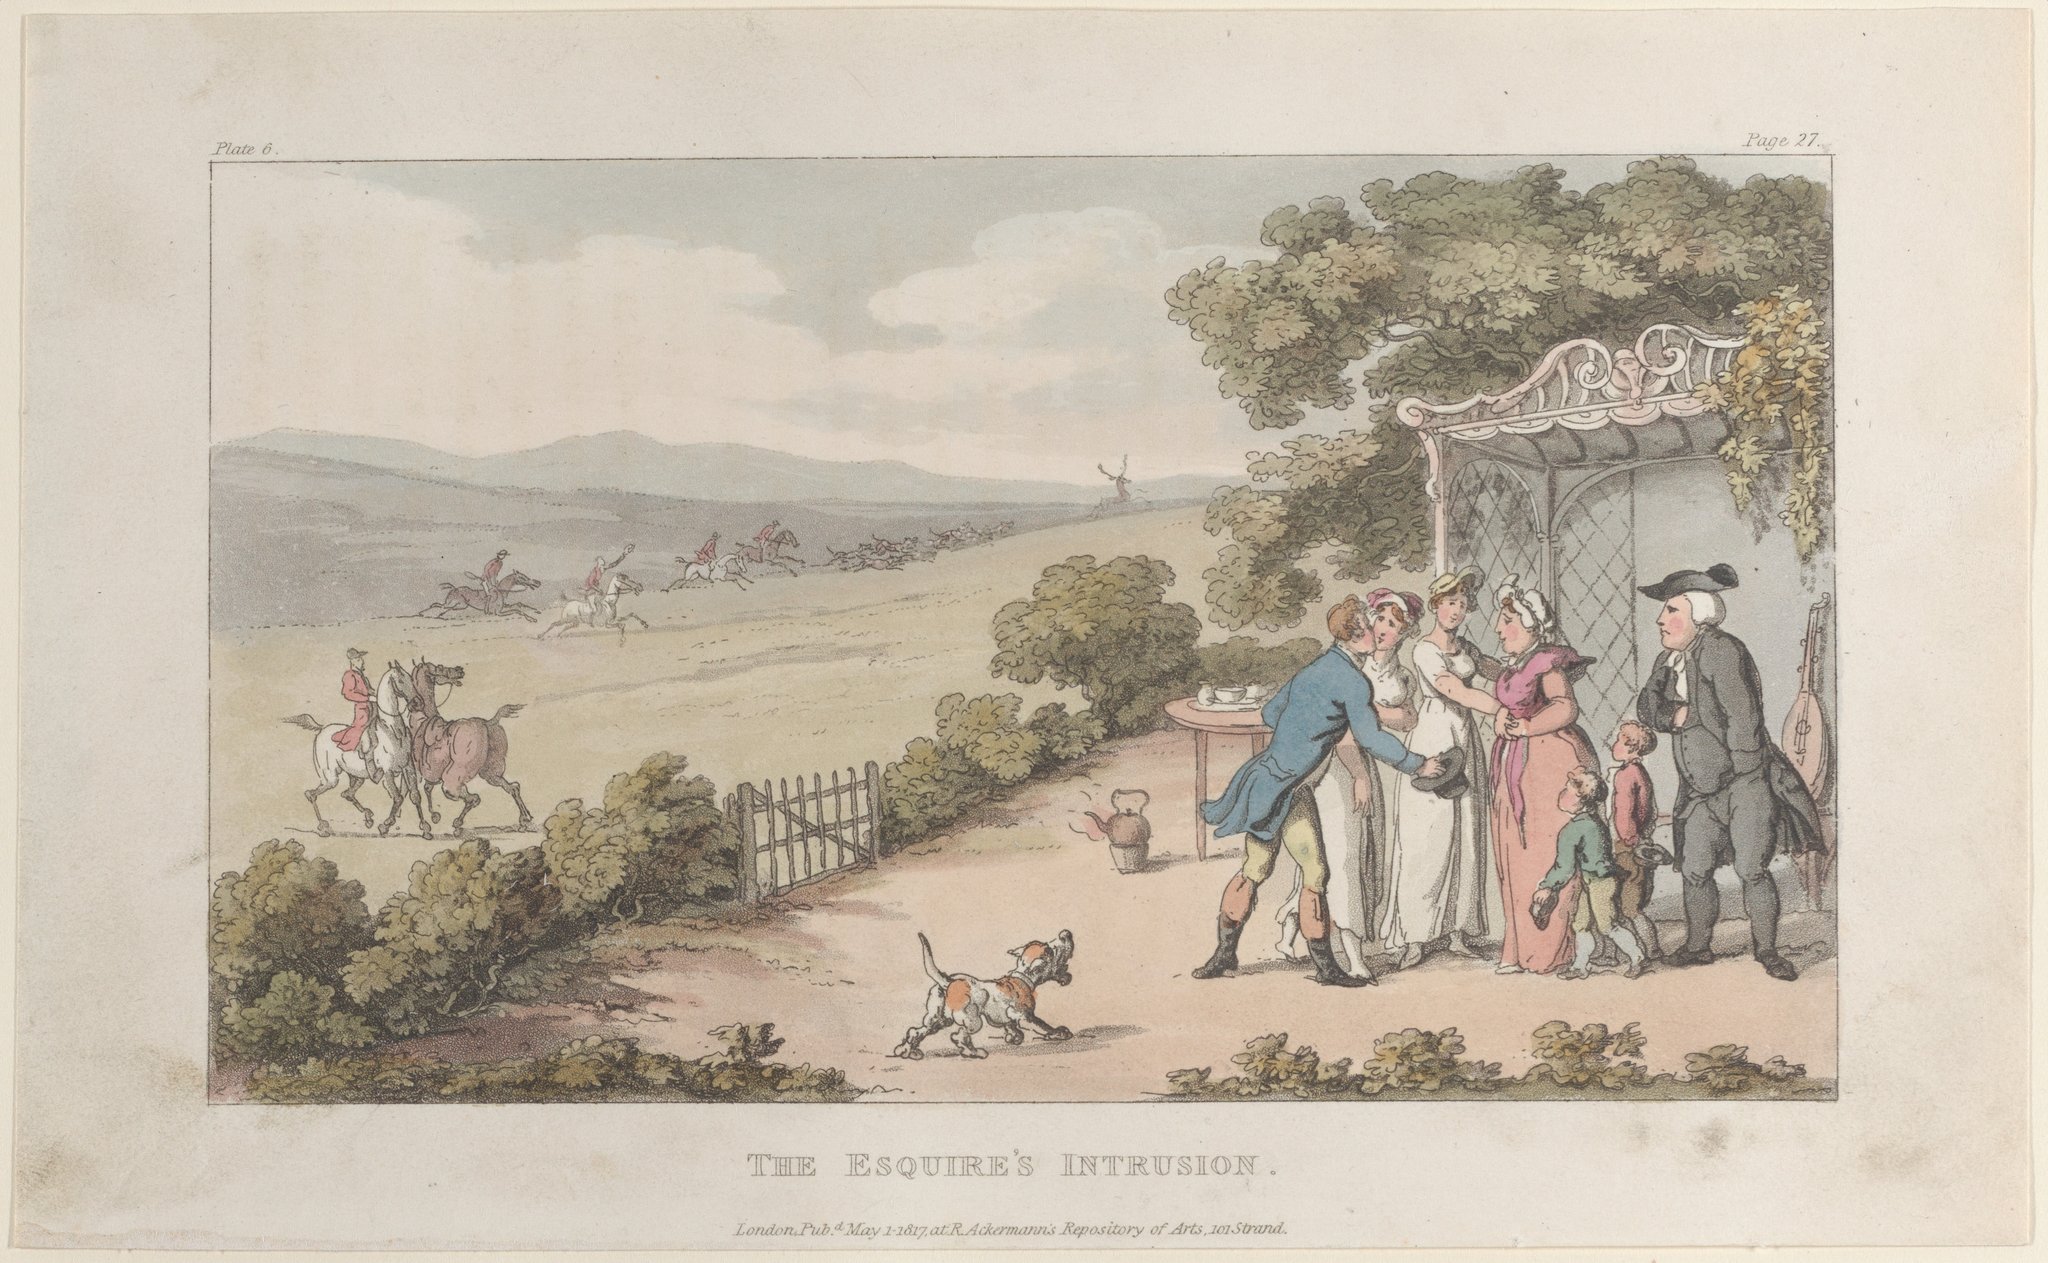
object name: print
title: The Esquire's Intrusion, from "The Vicar of Wakefield"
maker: thomas rowlandson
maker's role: artist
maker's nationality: british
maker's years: 1757-1827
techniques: aquatint, etching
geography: london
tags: men,women,dogs,horses